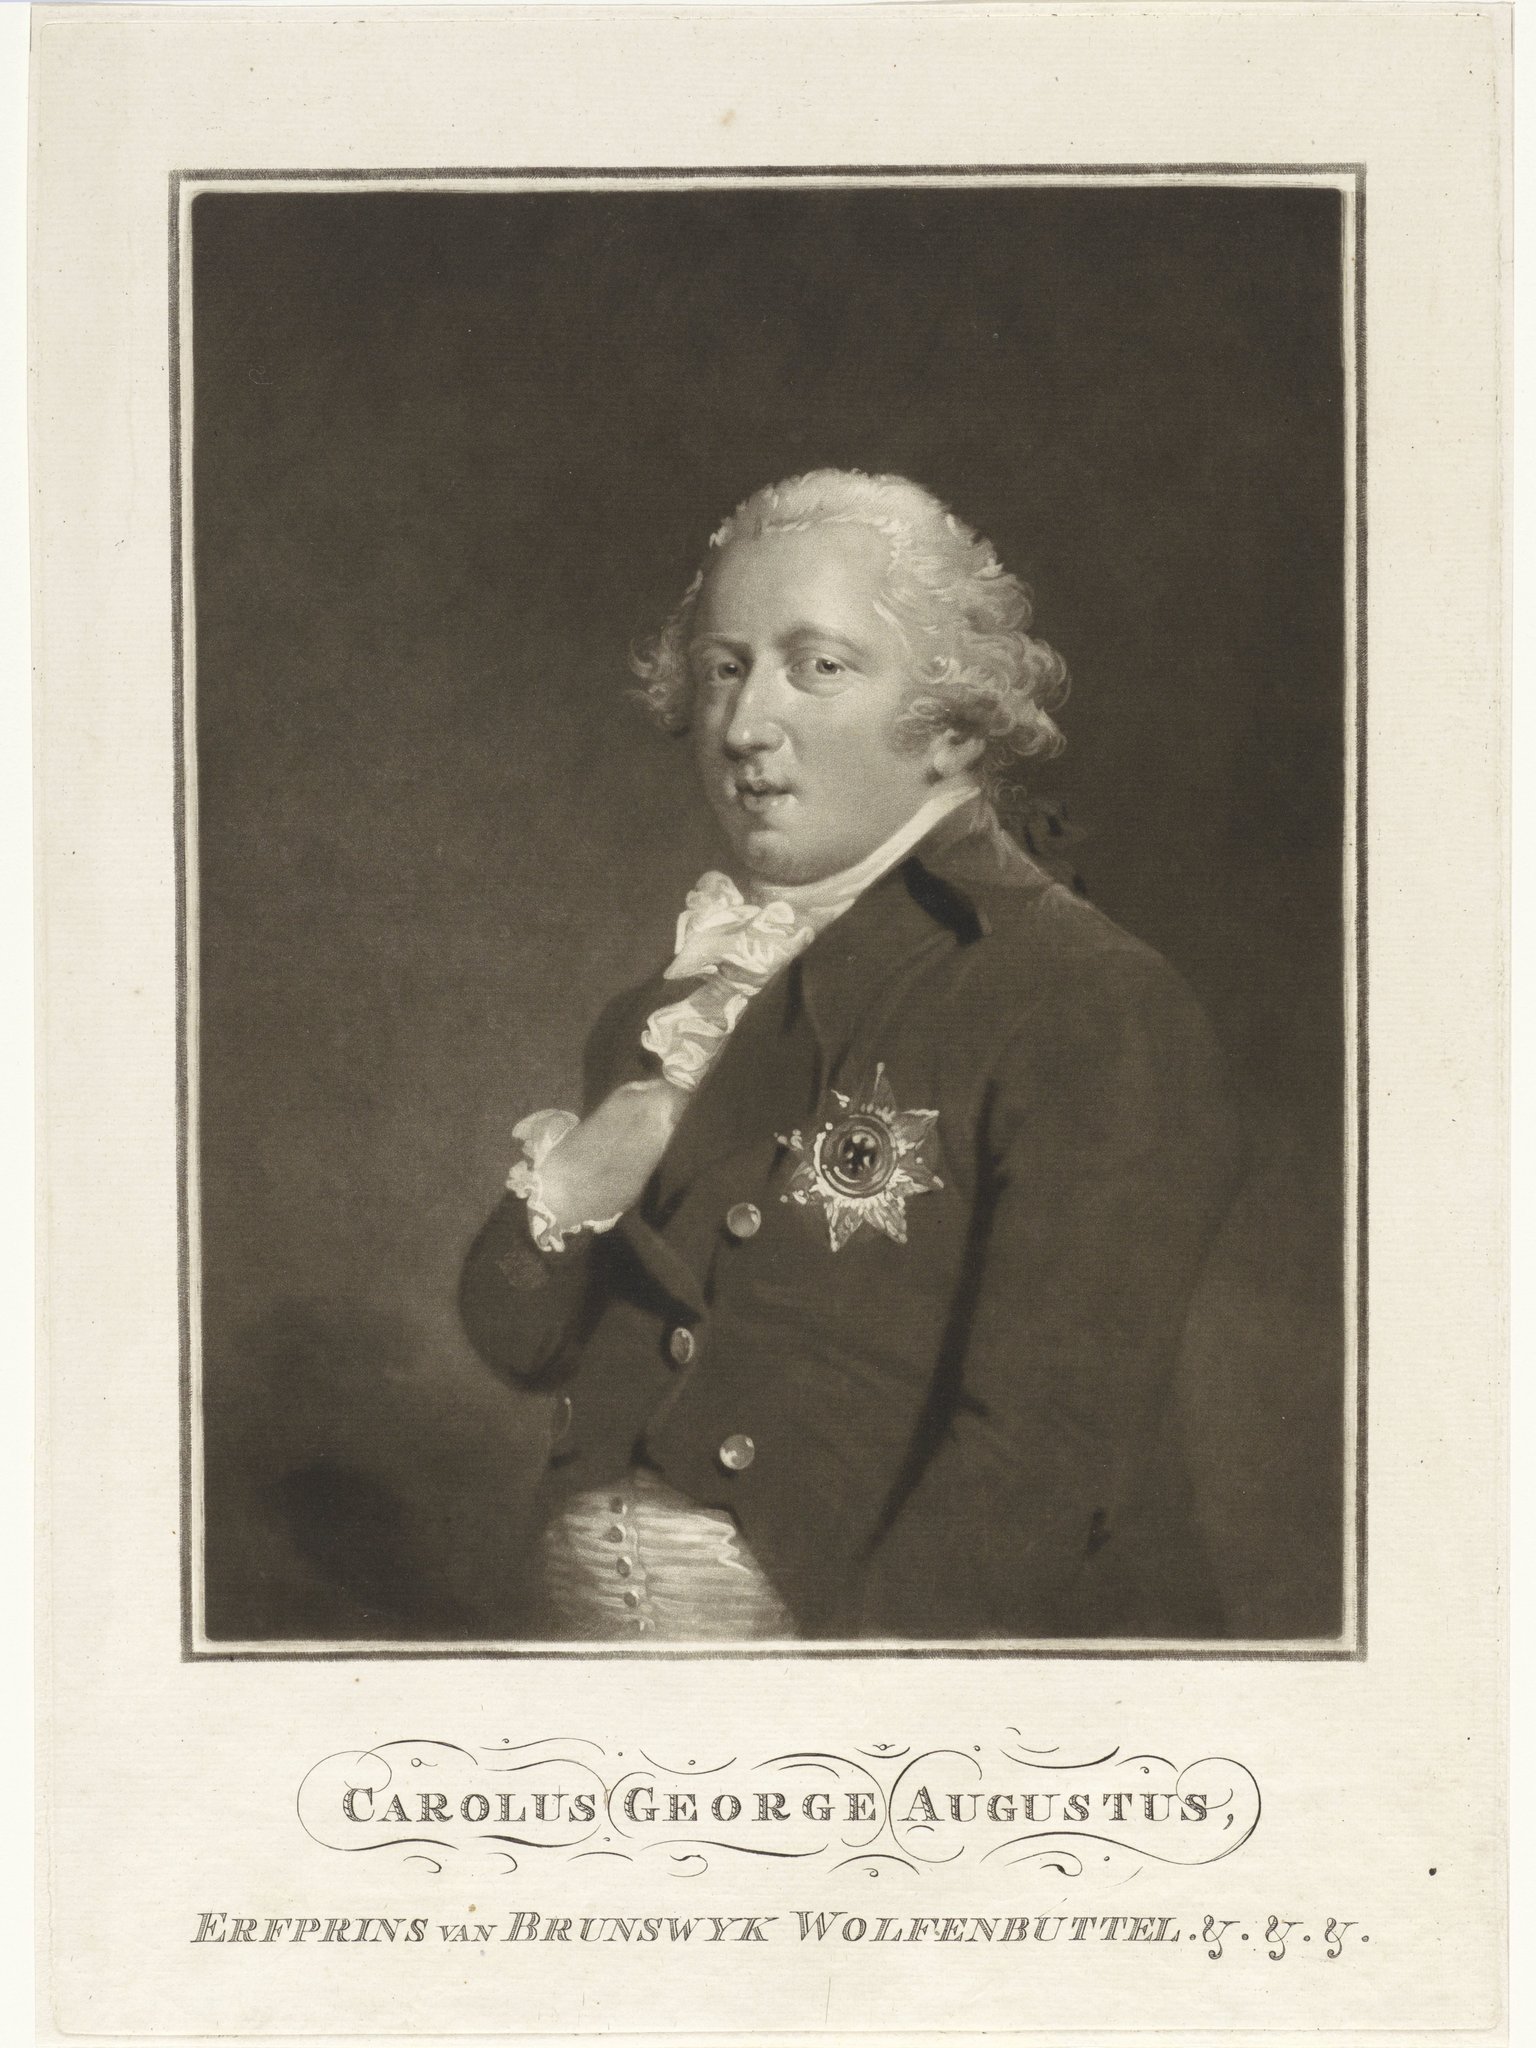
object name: print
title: Portret van Karel George August, erfprins van Brunswijk-Wolfenbüttel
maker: charles howard hodges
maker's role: draughtsman, painter, print maker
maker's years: 1764-1837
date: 1794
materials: paper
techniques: engraving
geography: amsterdam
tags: karel van brunswijk-wolfenbüttel